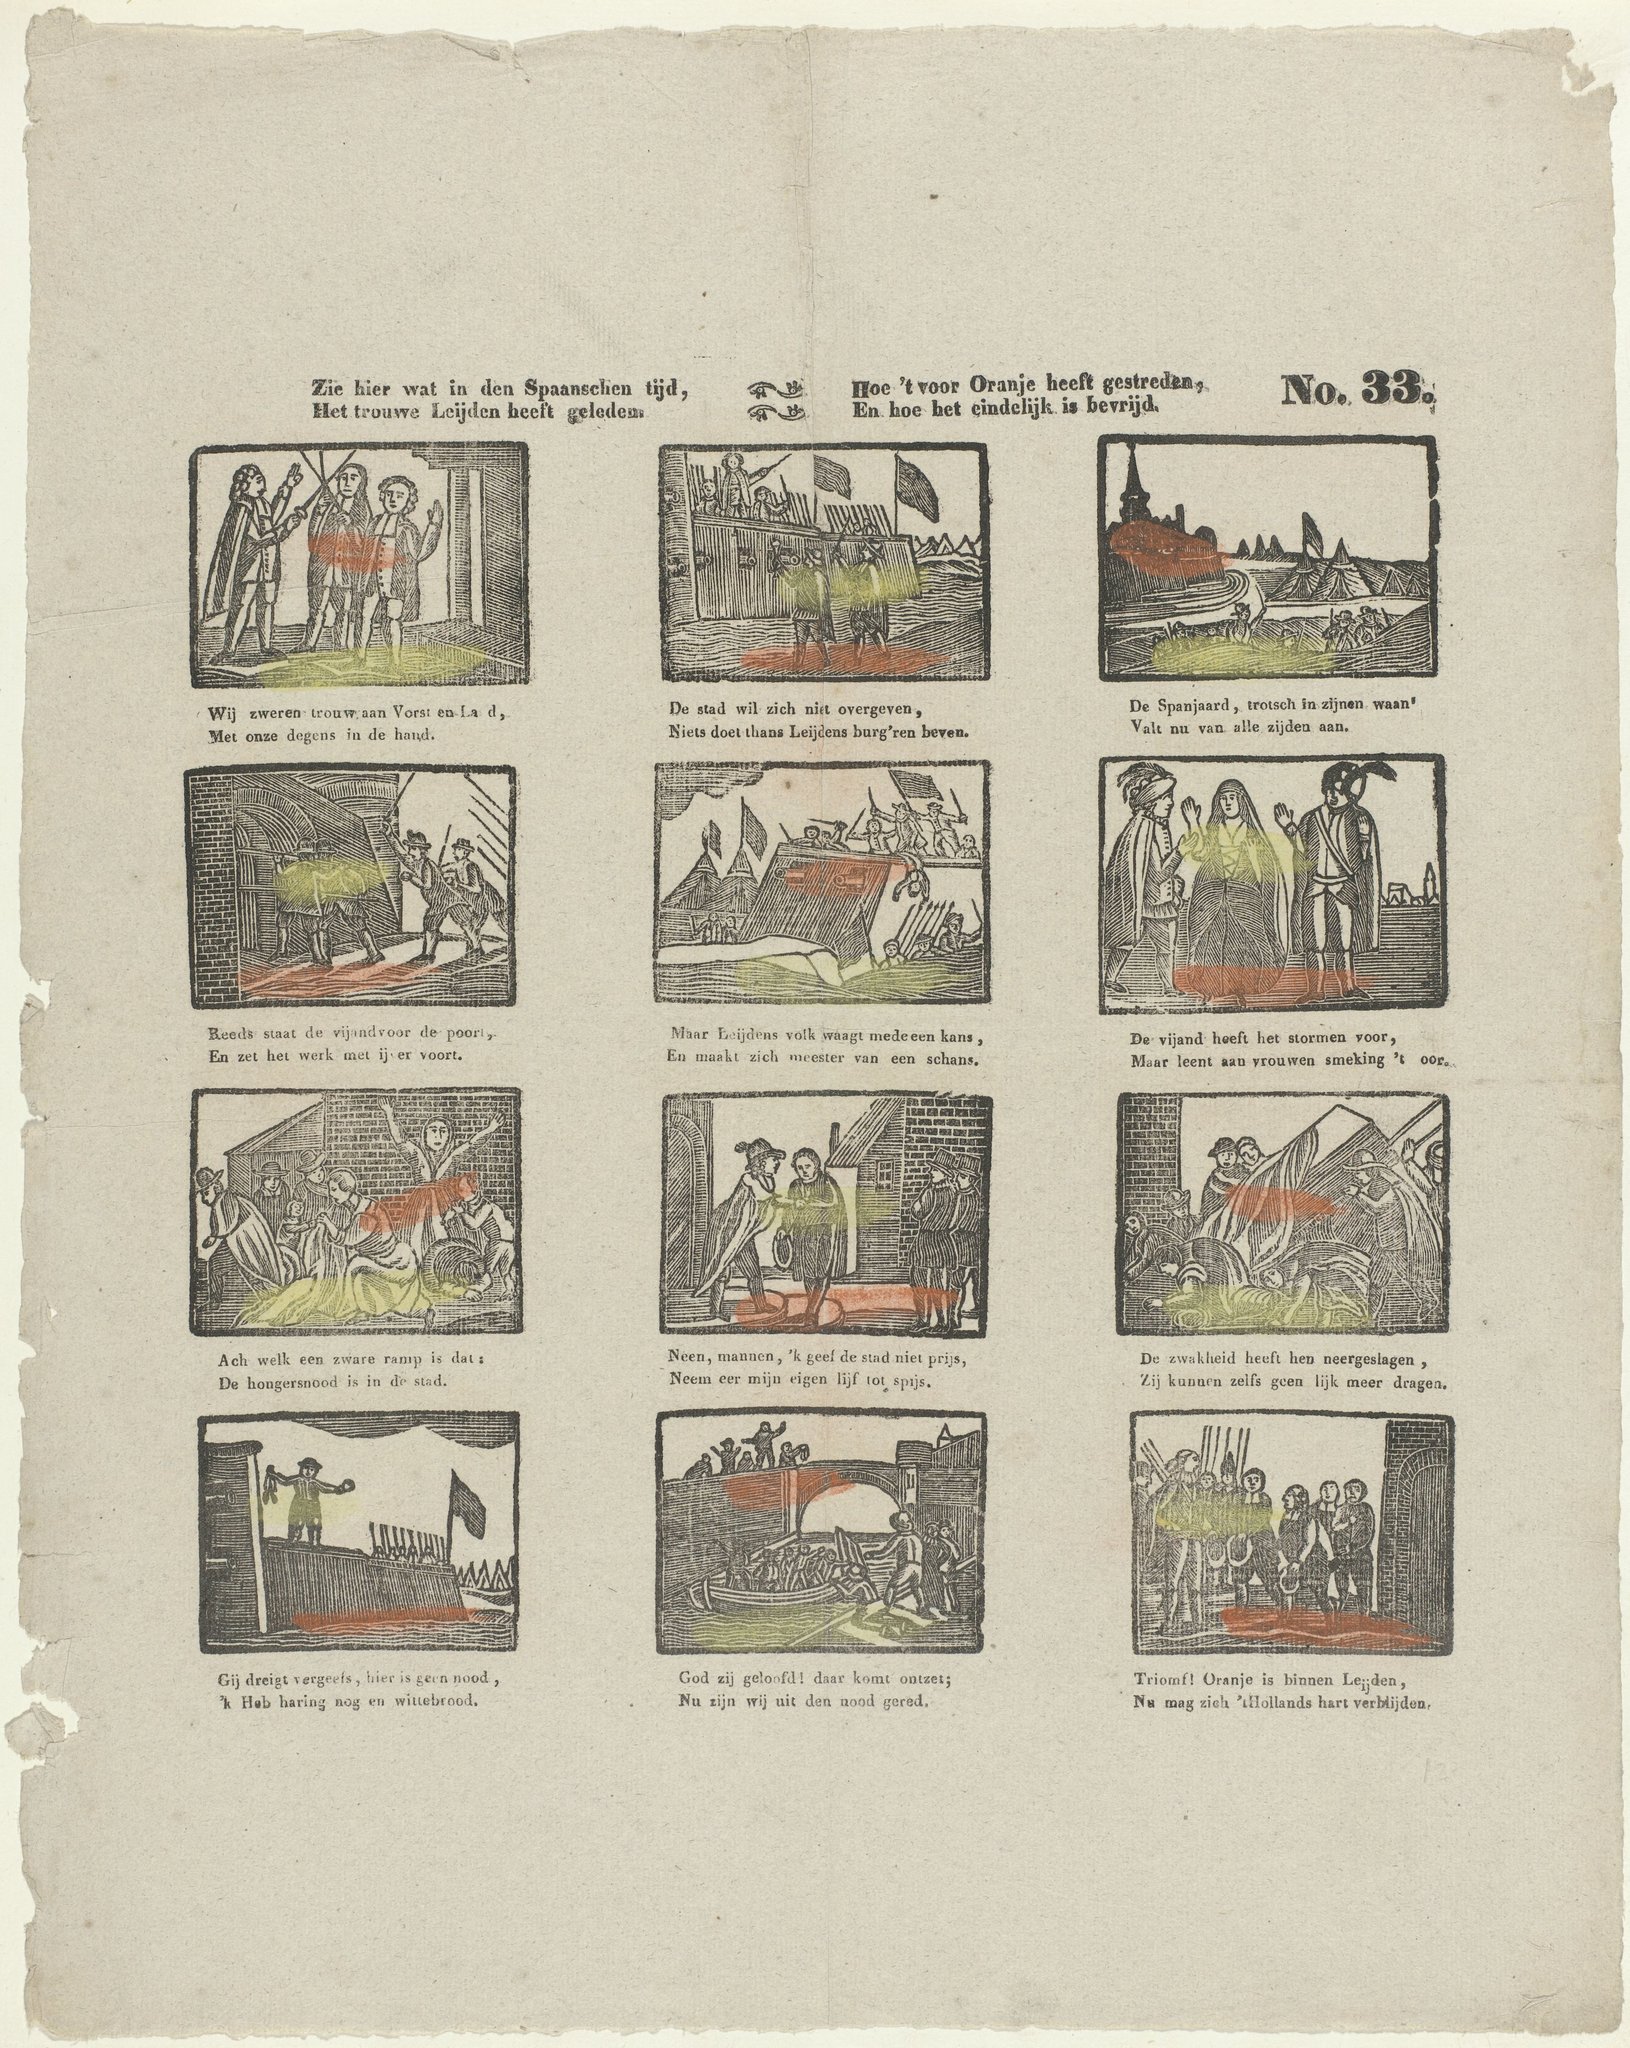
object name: print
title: Wat onder 't Spaansche jok Oud-Holland heeft geleden, / En hoe 't met moed steeds voor zijn vrijheid heeft gestreden; / Gelijk 't beschreven staat in de historieblaan, / Toont, lieve kinderen, deez' fraaije prent u aan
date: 1832-1850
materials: paper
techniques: colour, letterpress printing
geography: rotterdam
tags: history, siege, leiden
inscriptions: collector's mark: Lugt 2760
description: Blad met 12 voorstellingen over het beleg en ontzet van Leiden. Onder elke afbeelding een tweeregelig vers. Genummerd rechtsboven: No. 33.